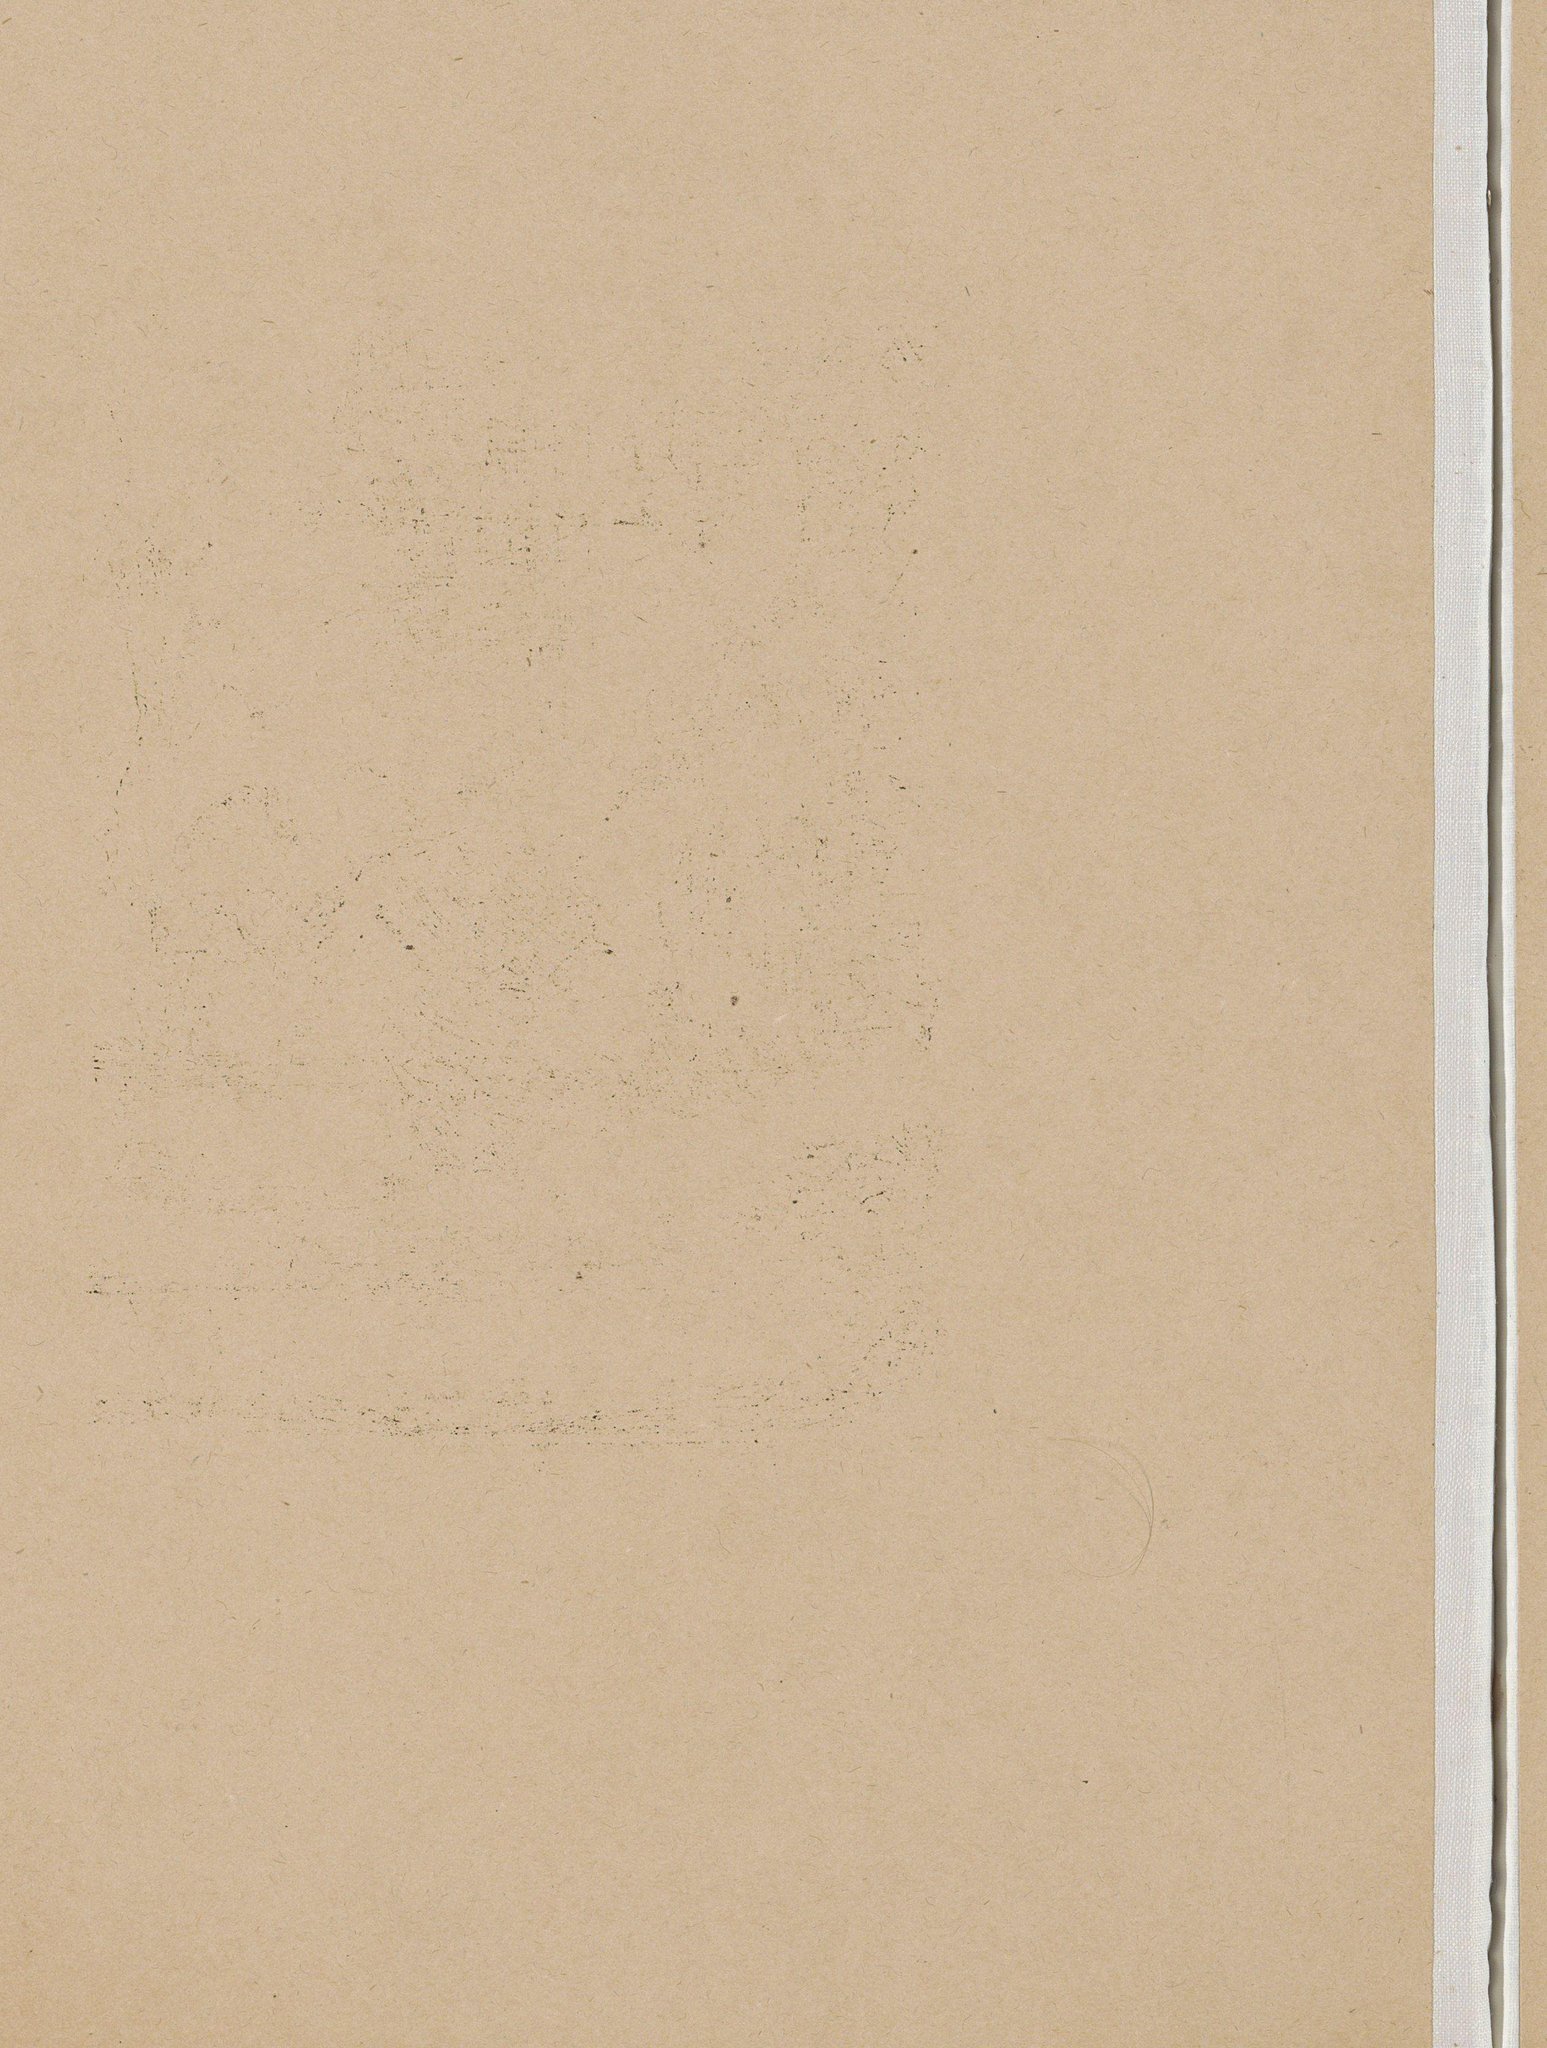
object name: sketchbook leaf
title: Abklatsch van een krijttekening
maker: willem witsen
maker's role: draughtsman, painter, print maker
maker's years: 1860-1923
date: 1874-1923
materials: paper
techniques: printmaking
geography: ewijkshoeve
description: Pagina 12 uit een schetsboek met 72 bladen.